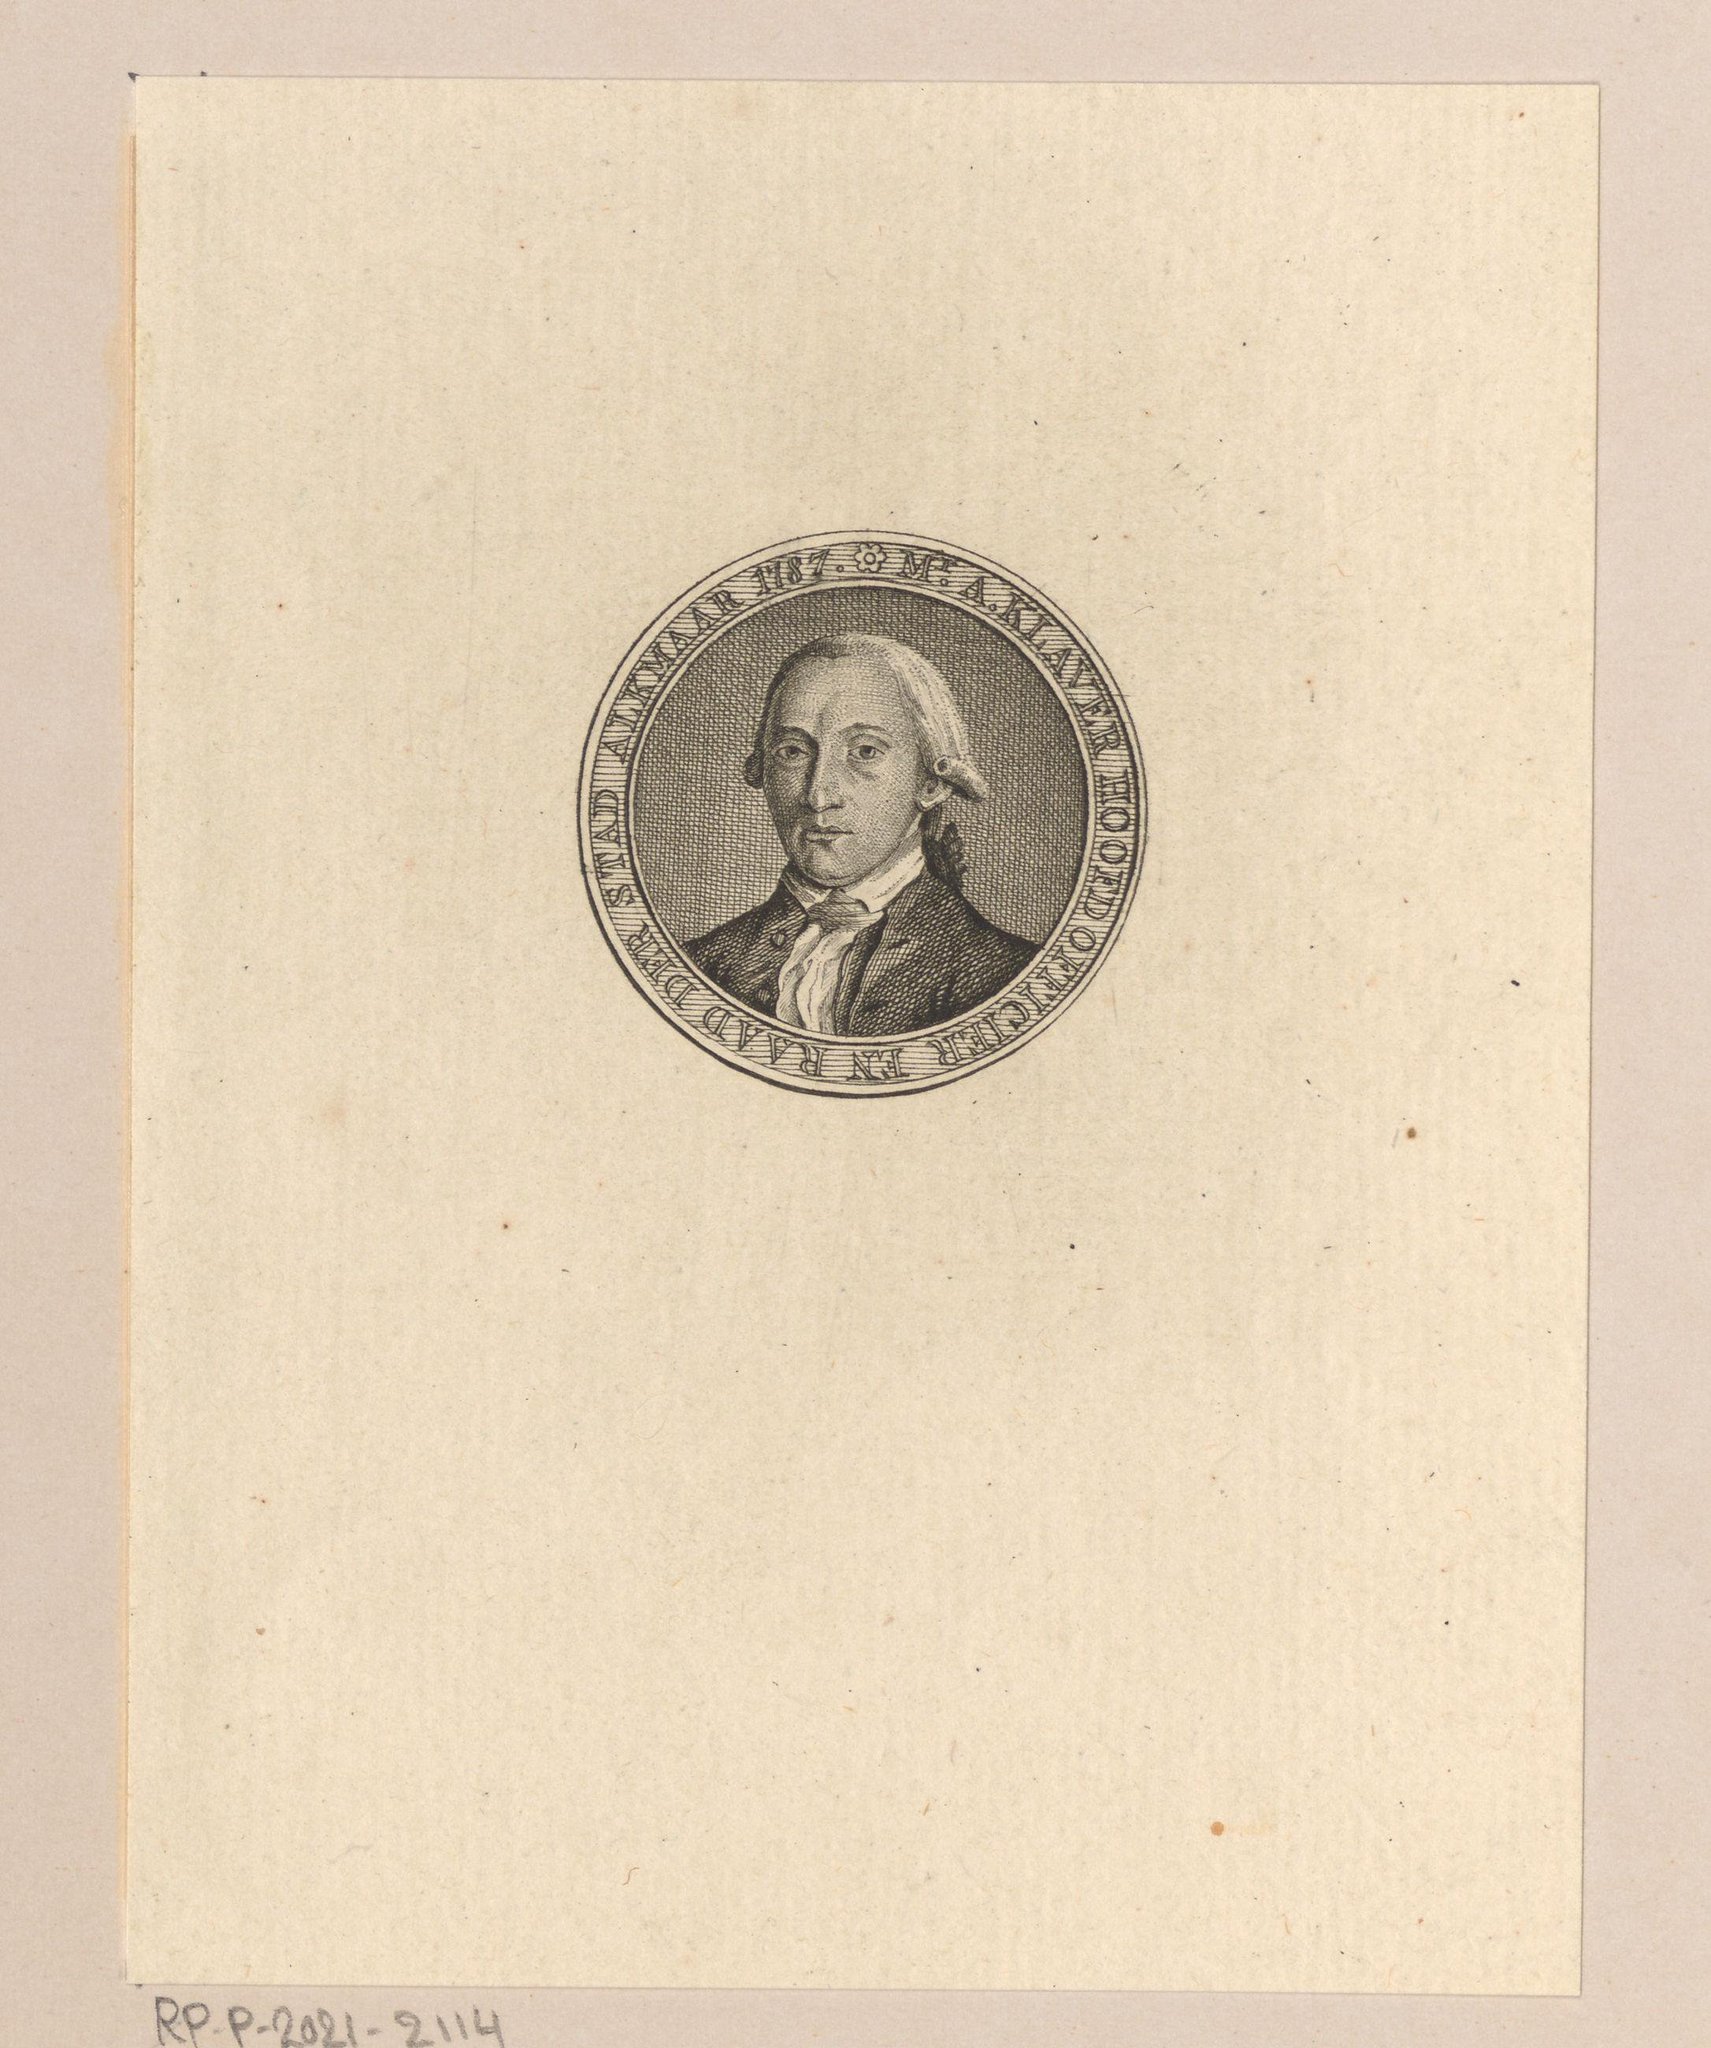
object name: print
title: Portretten van patriotten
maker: abraham jacobsz. hulk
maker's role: print maker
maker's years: 1751-1817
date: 1787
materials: paper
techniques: engraving, etching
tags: historical persons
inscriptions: date